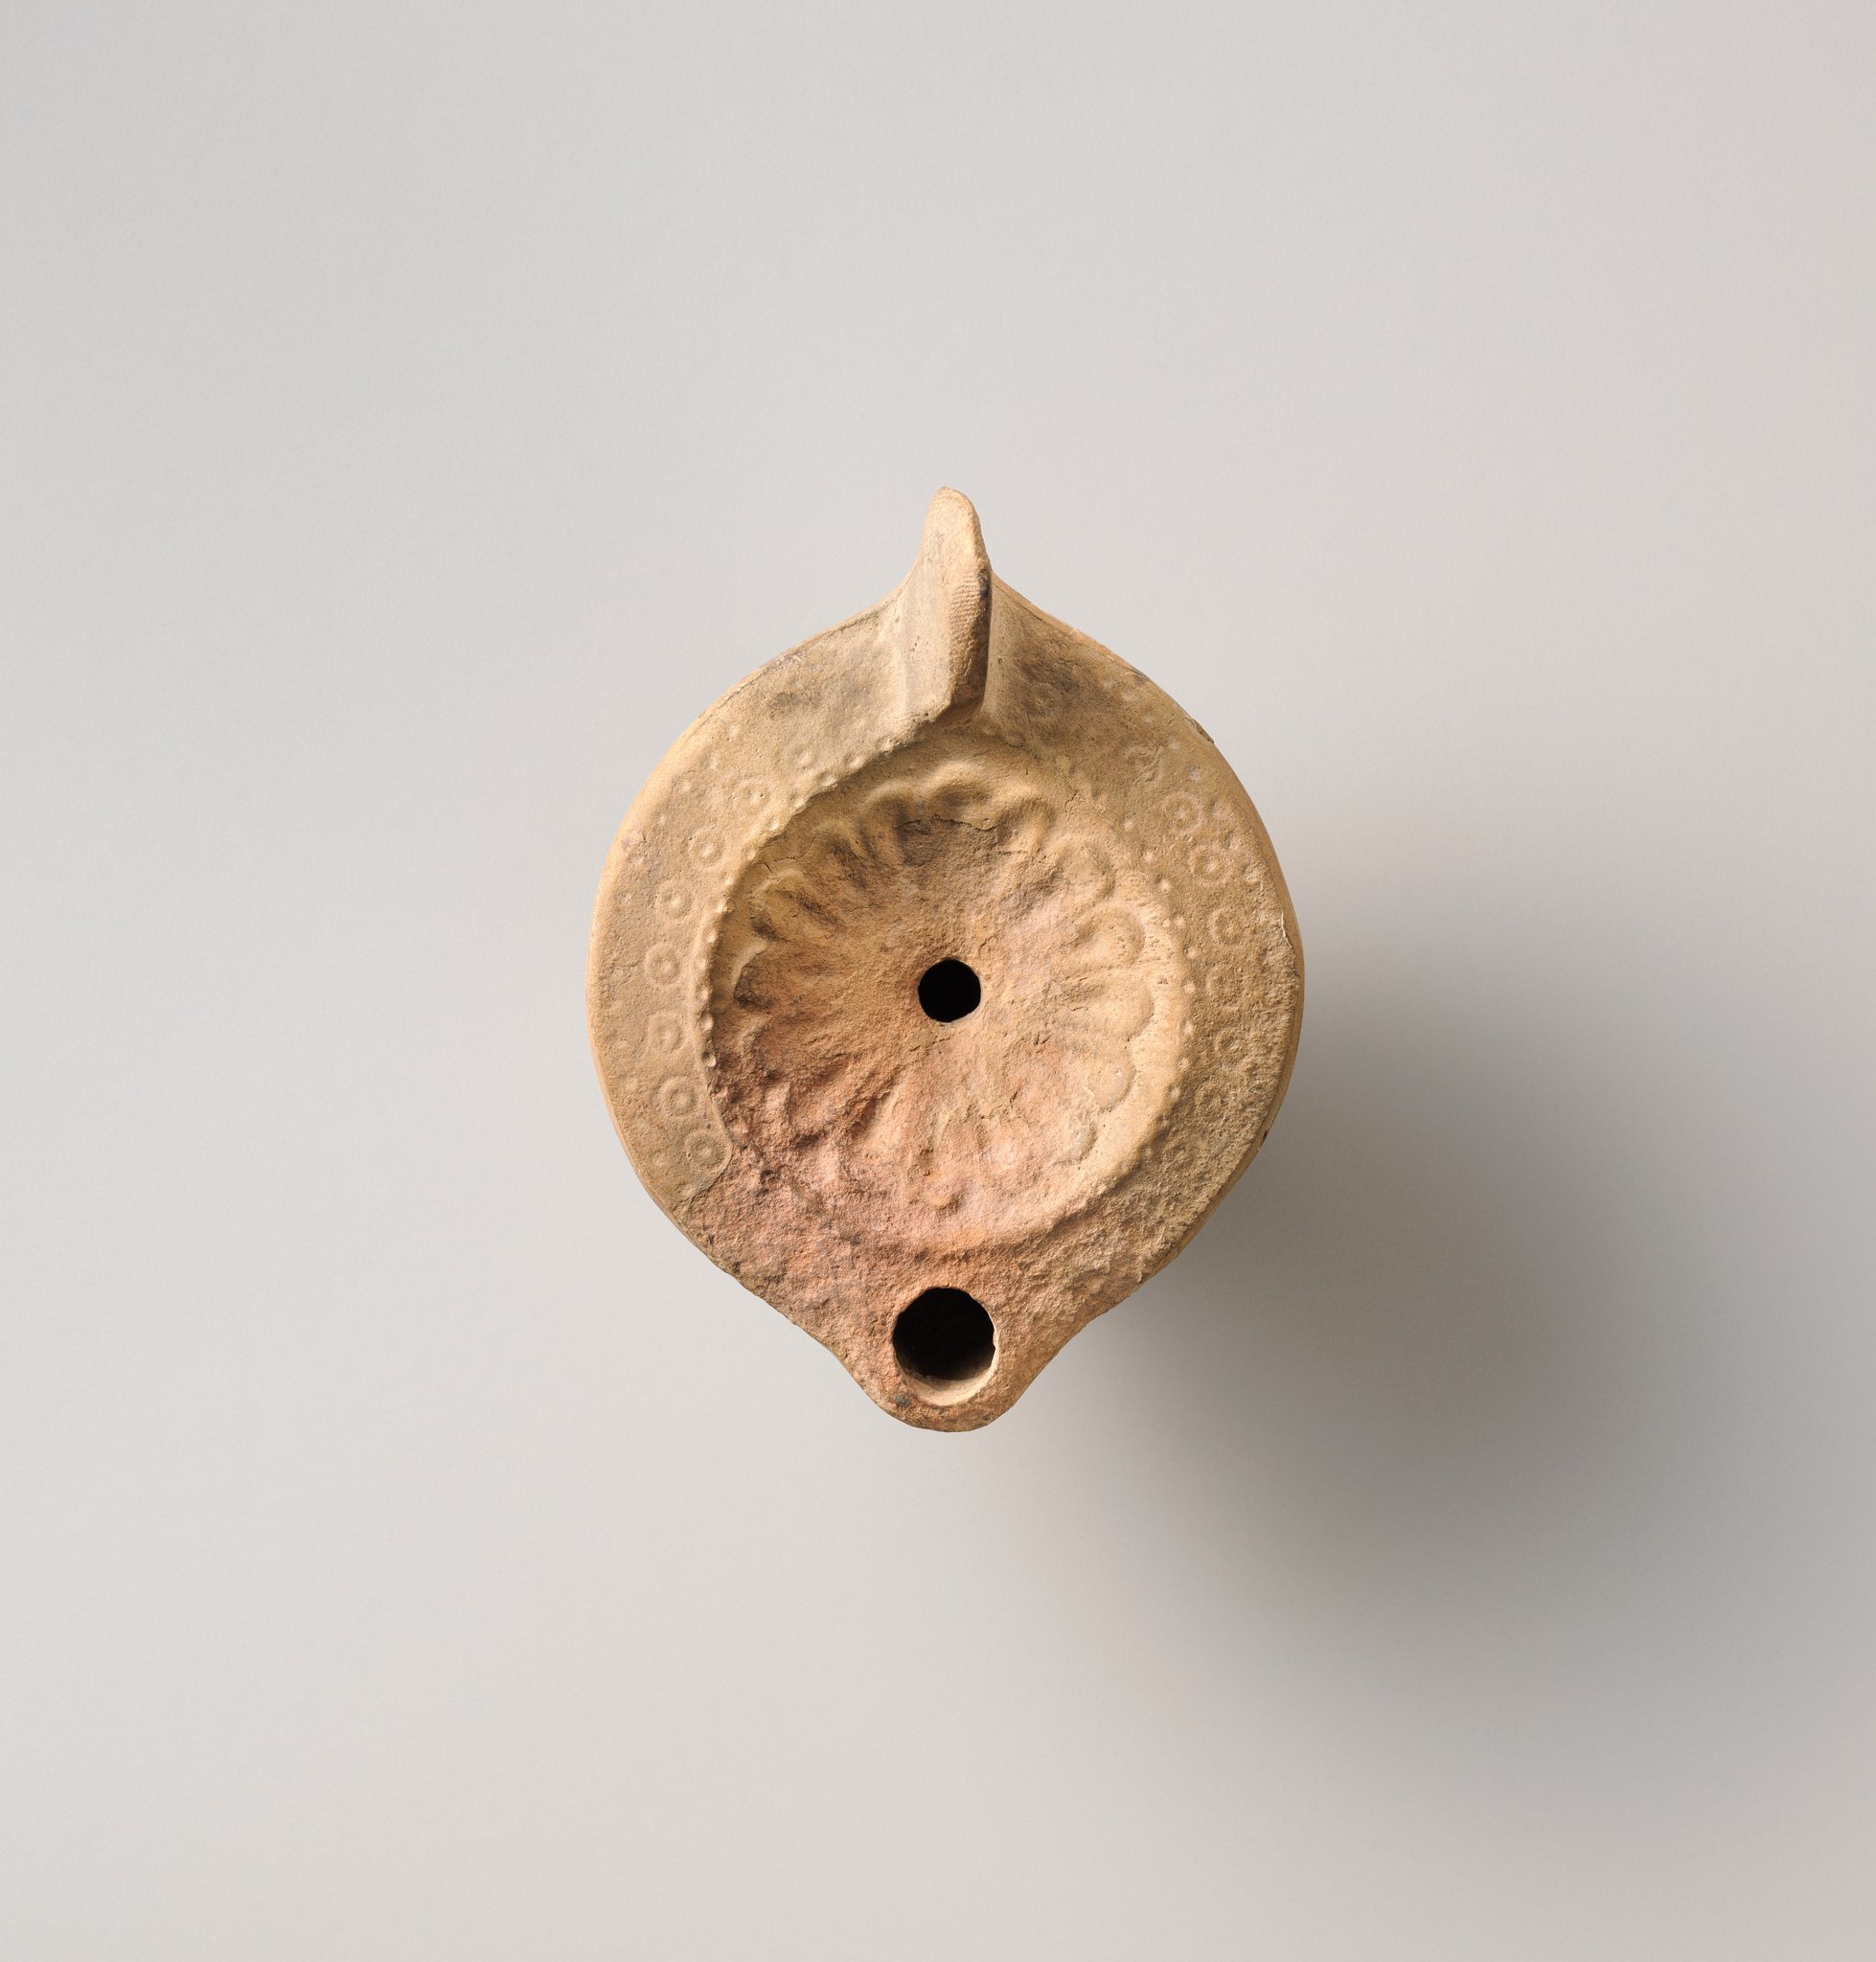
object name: lamp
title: Terracotta oil lamp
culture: roman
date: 101-200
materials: terracotta